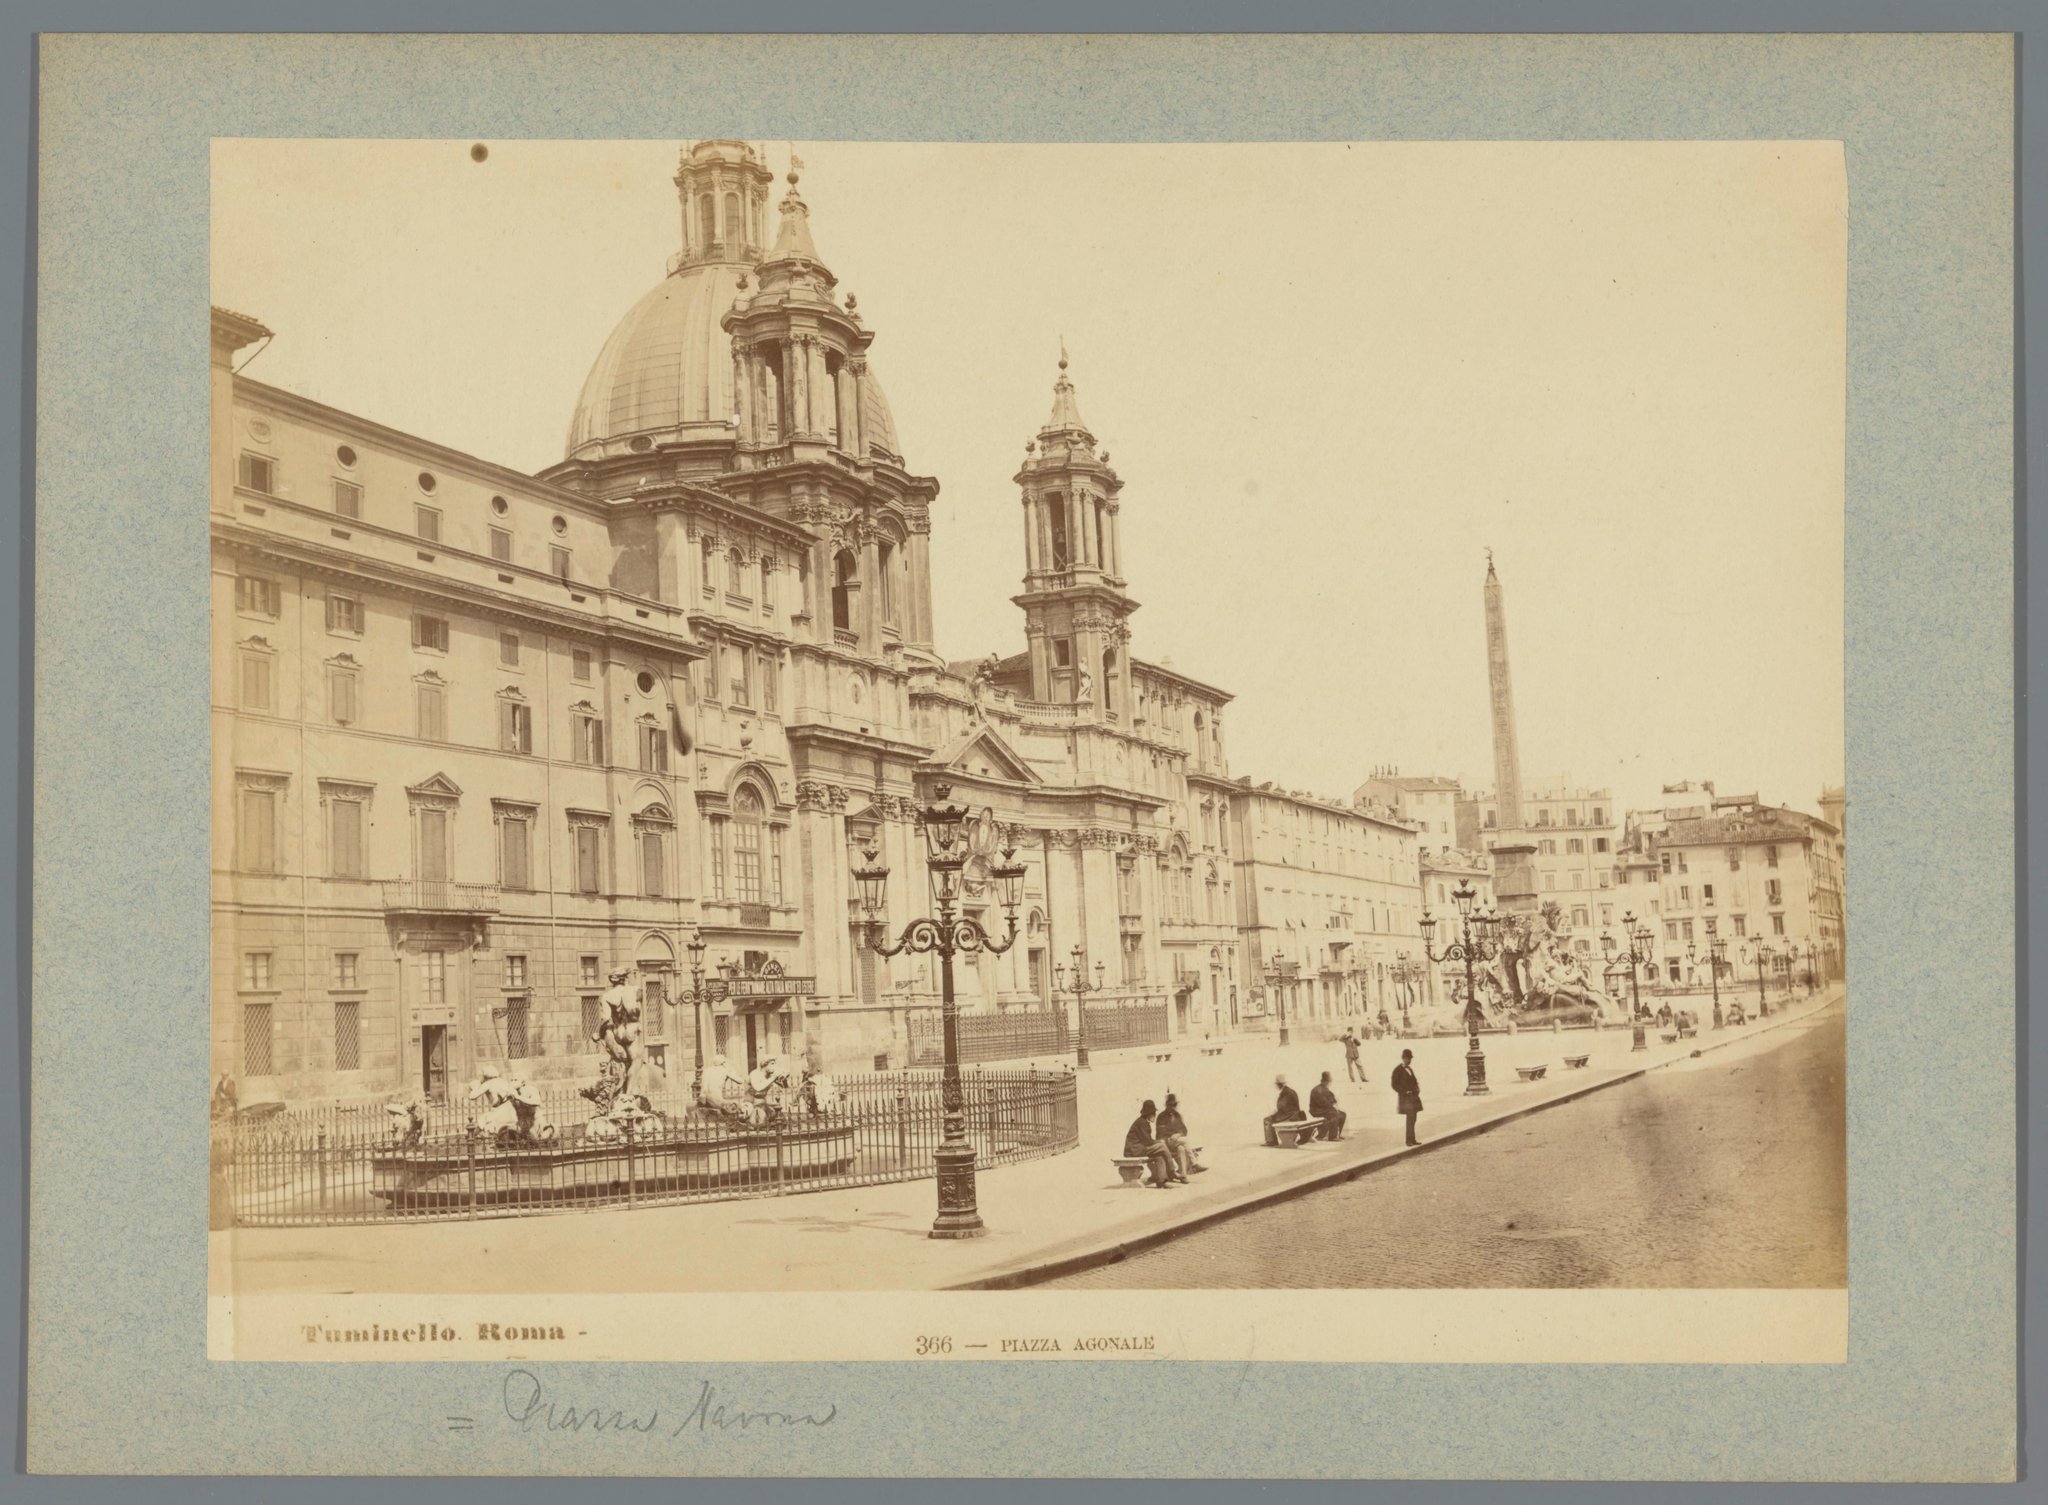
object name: photograph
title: Piazza Agonale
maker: ludovico tuminello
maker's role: fotograaf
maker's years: 1824-1907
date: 1851-1900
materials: cardboard, paper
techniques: albumen print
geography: rome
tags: square, place, circus, etc., obelisk, needle, church (exterior), ornamental fountain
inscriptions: number: ‘366’, inscription: ‘= Piazza Navona’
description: Links de Sant'Agnese in Agone en rechtsachter de Vier Stromenfontein van Bernini.